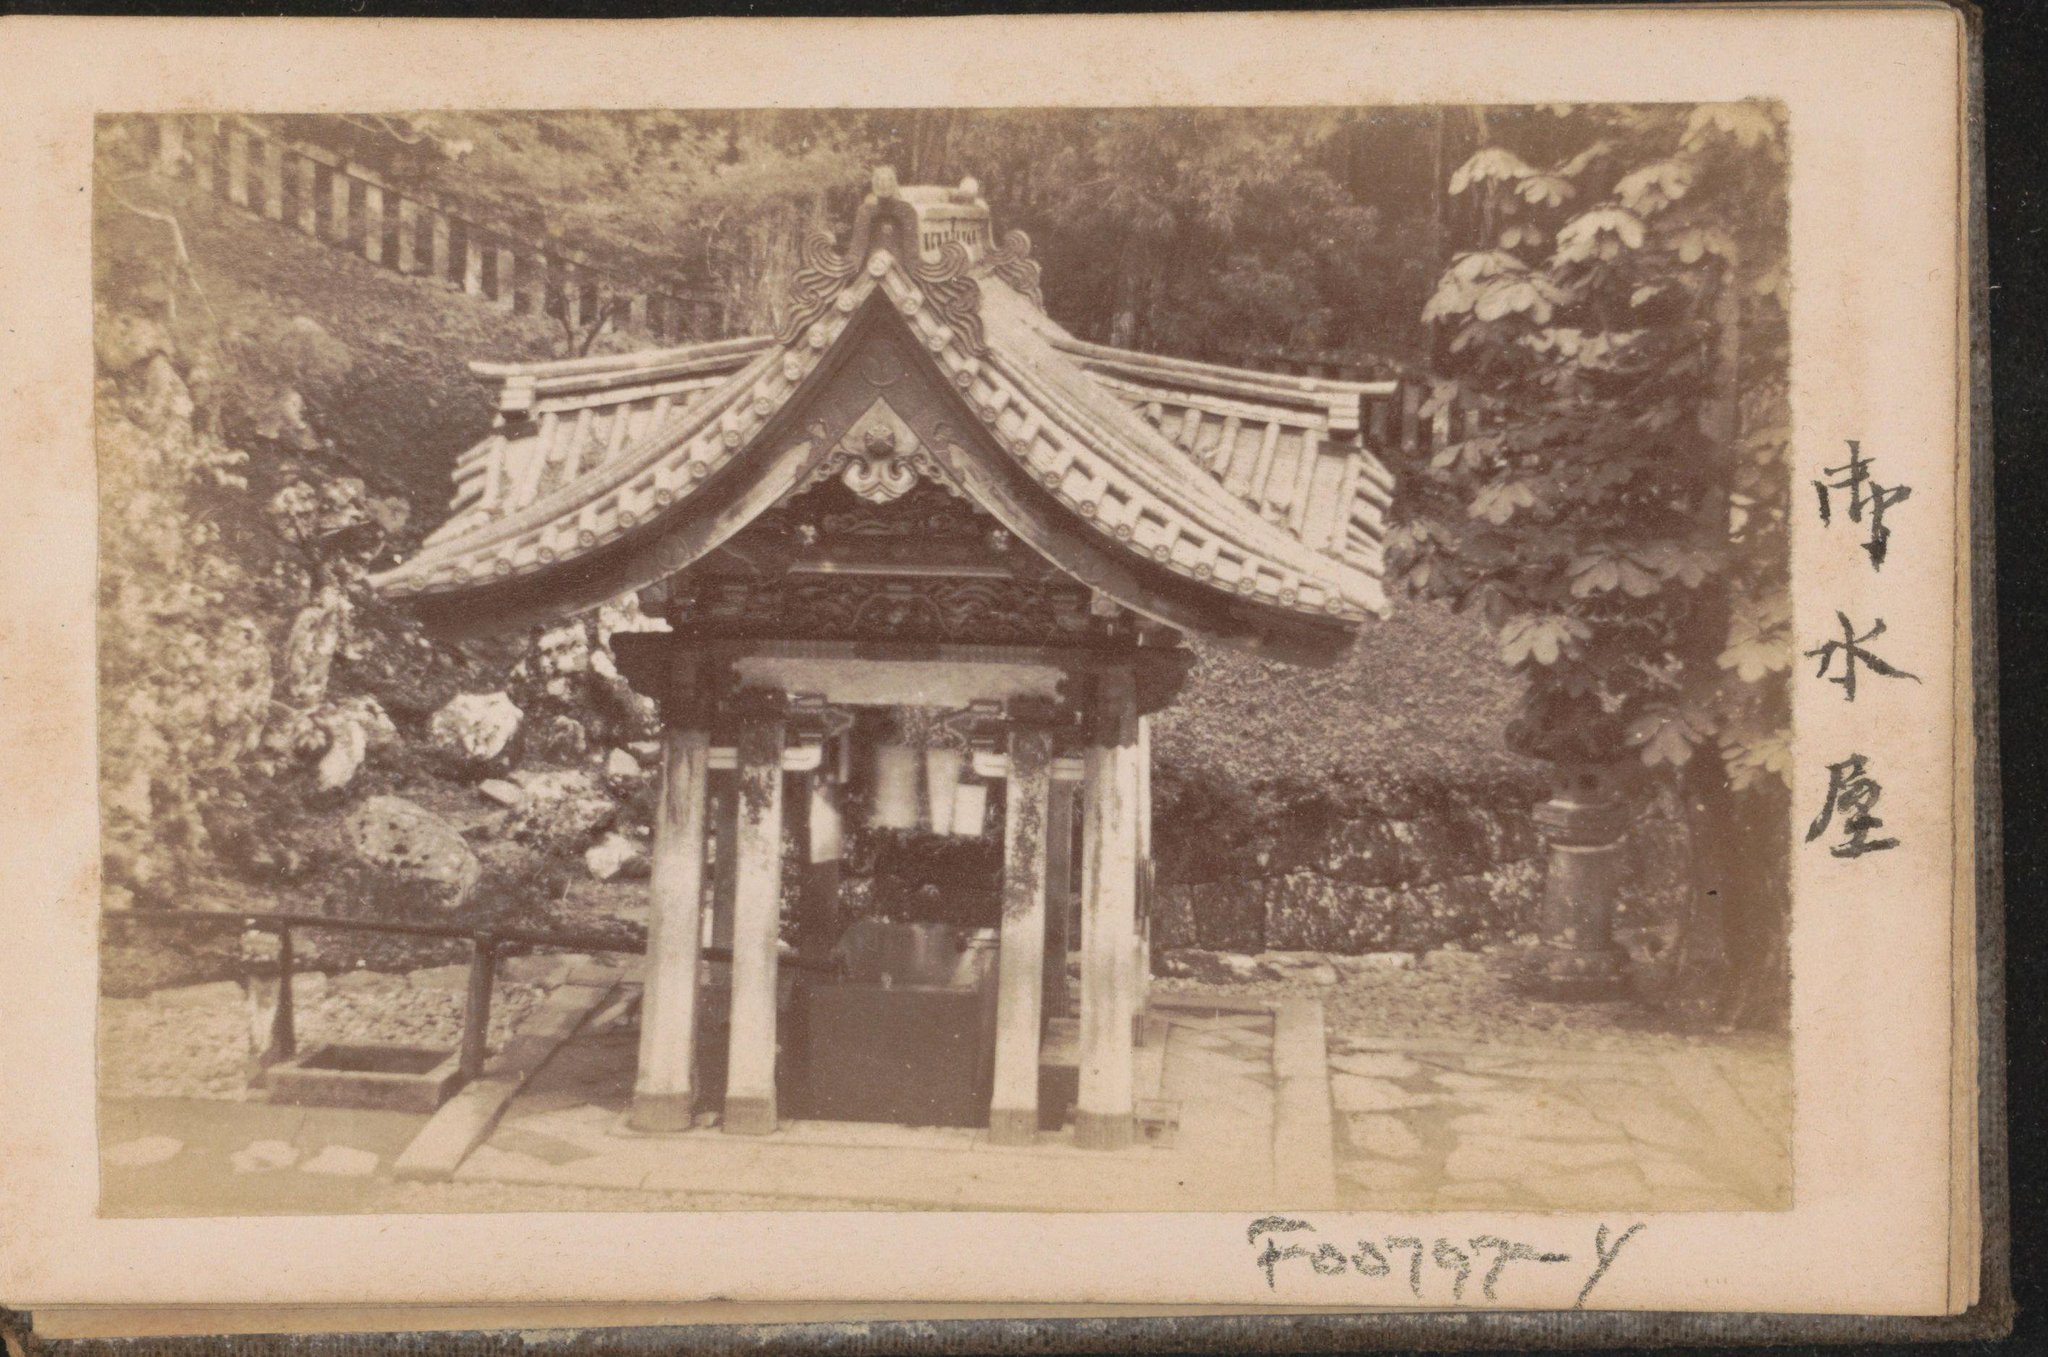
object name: photograph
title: Exterieur van tempelgebouwen in Japan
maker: Anonymous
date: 1870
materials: paper, photographic support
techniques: albumen print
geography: japan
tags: temple, shrine ~ hinduism, buddhism, jainism, japan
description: Onderdeel van Leporelloalbum met 30 foto's van landschappen en gebouwen in Japan.